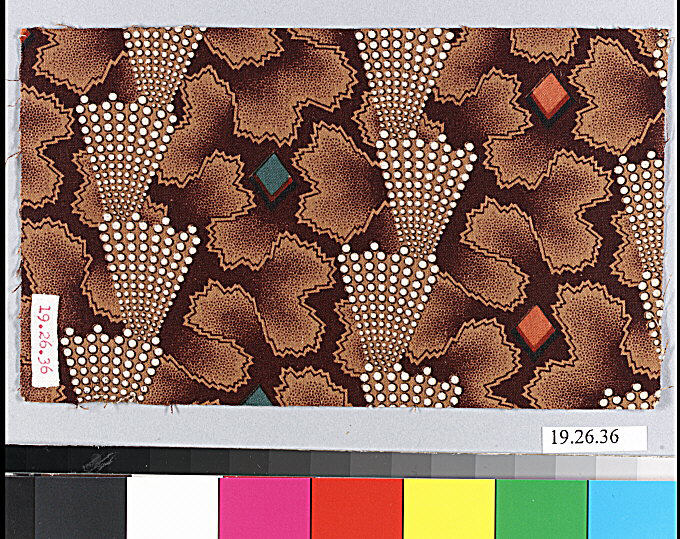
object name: sample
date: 1840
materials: cotton